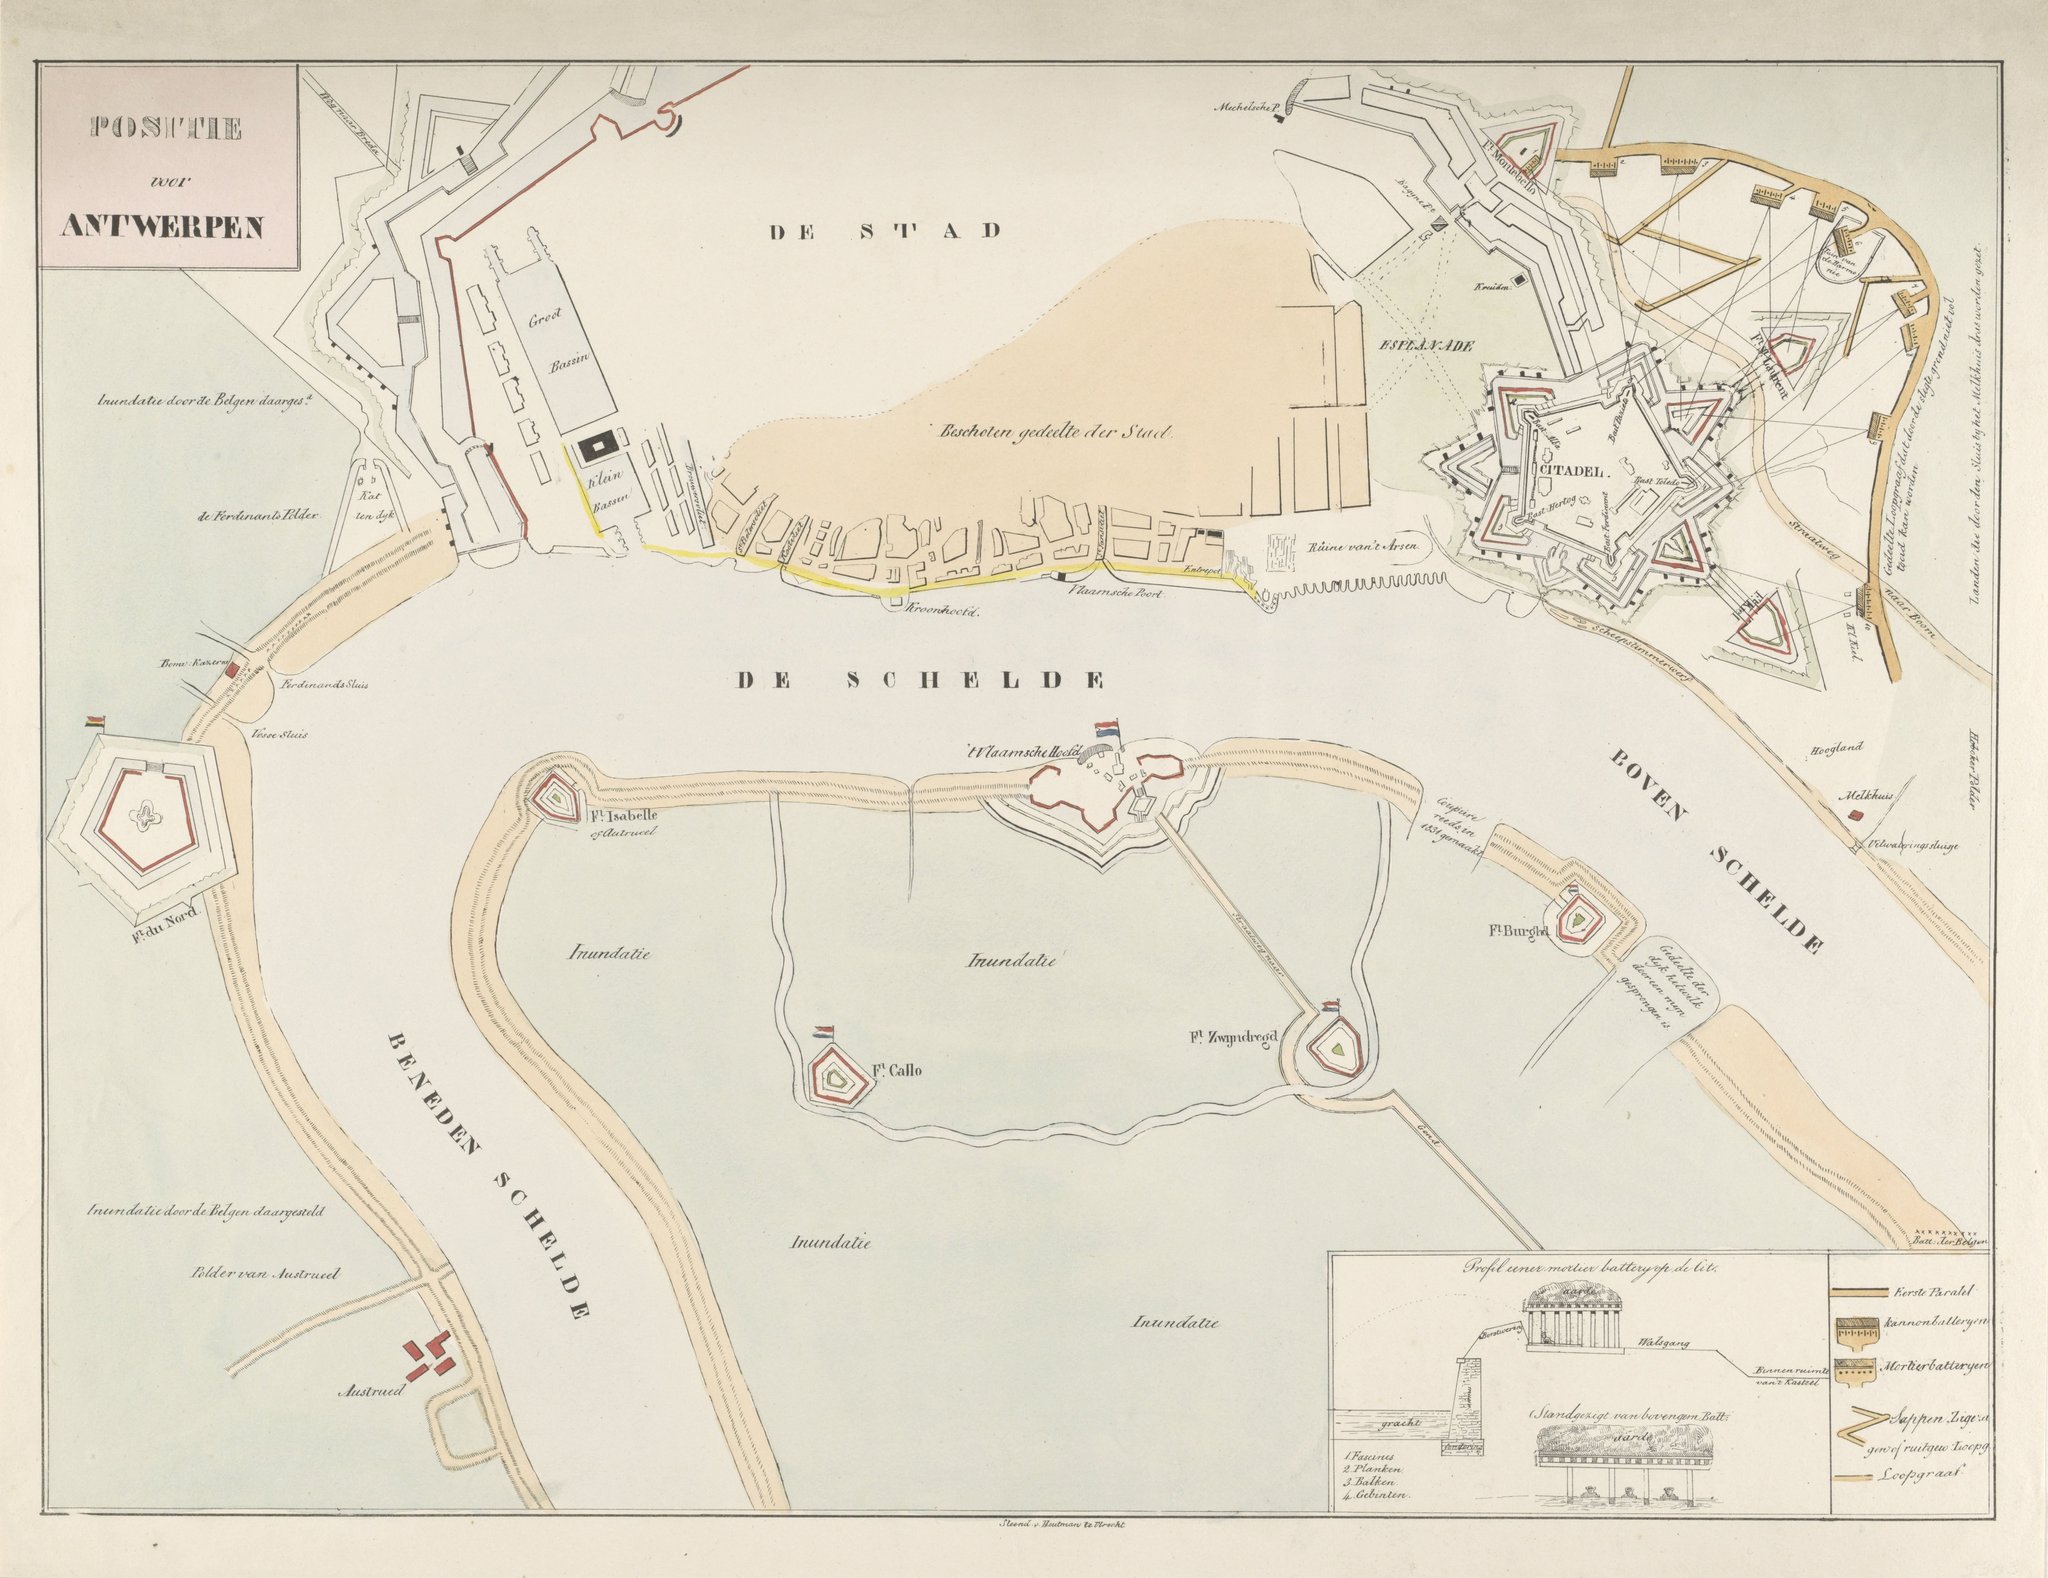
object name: map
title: Positie voor Antwerpen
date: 1832-1833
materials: paper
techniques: hand coloring, lithograph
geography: netherlands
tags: permanent fortifications, antwerp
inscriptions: collector's mark: Lugt 2228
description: Plan van de Schelde voor Antwerpen, met de Citadel en de andere forten in Nederlandse handen tijdens het beleg van de Citadel door de Fransen. Rechtsonder een inzet met twee afbeeldingen van een batterij op de Citadel en een legenda van de Franse belegeringswerken.